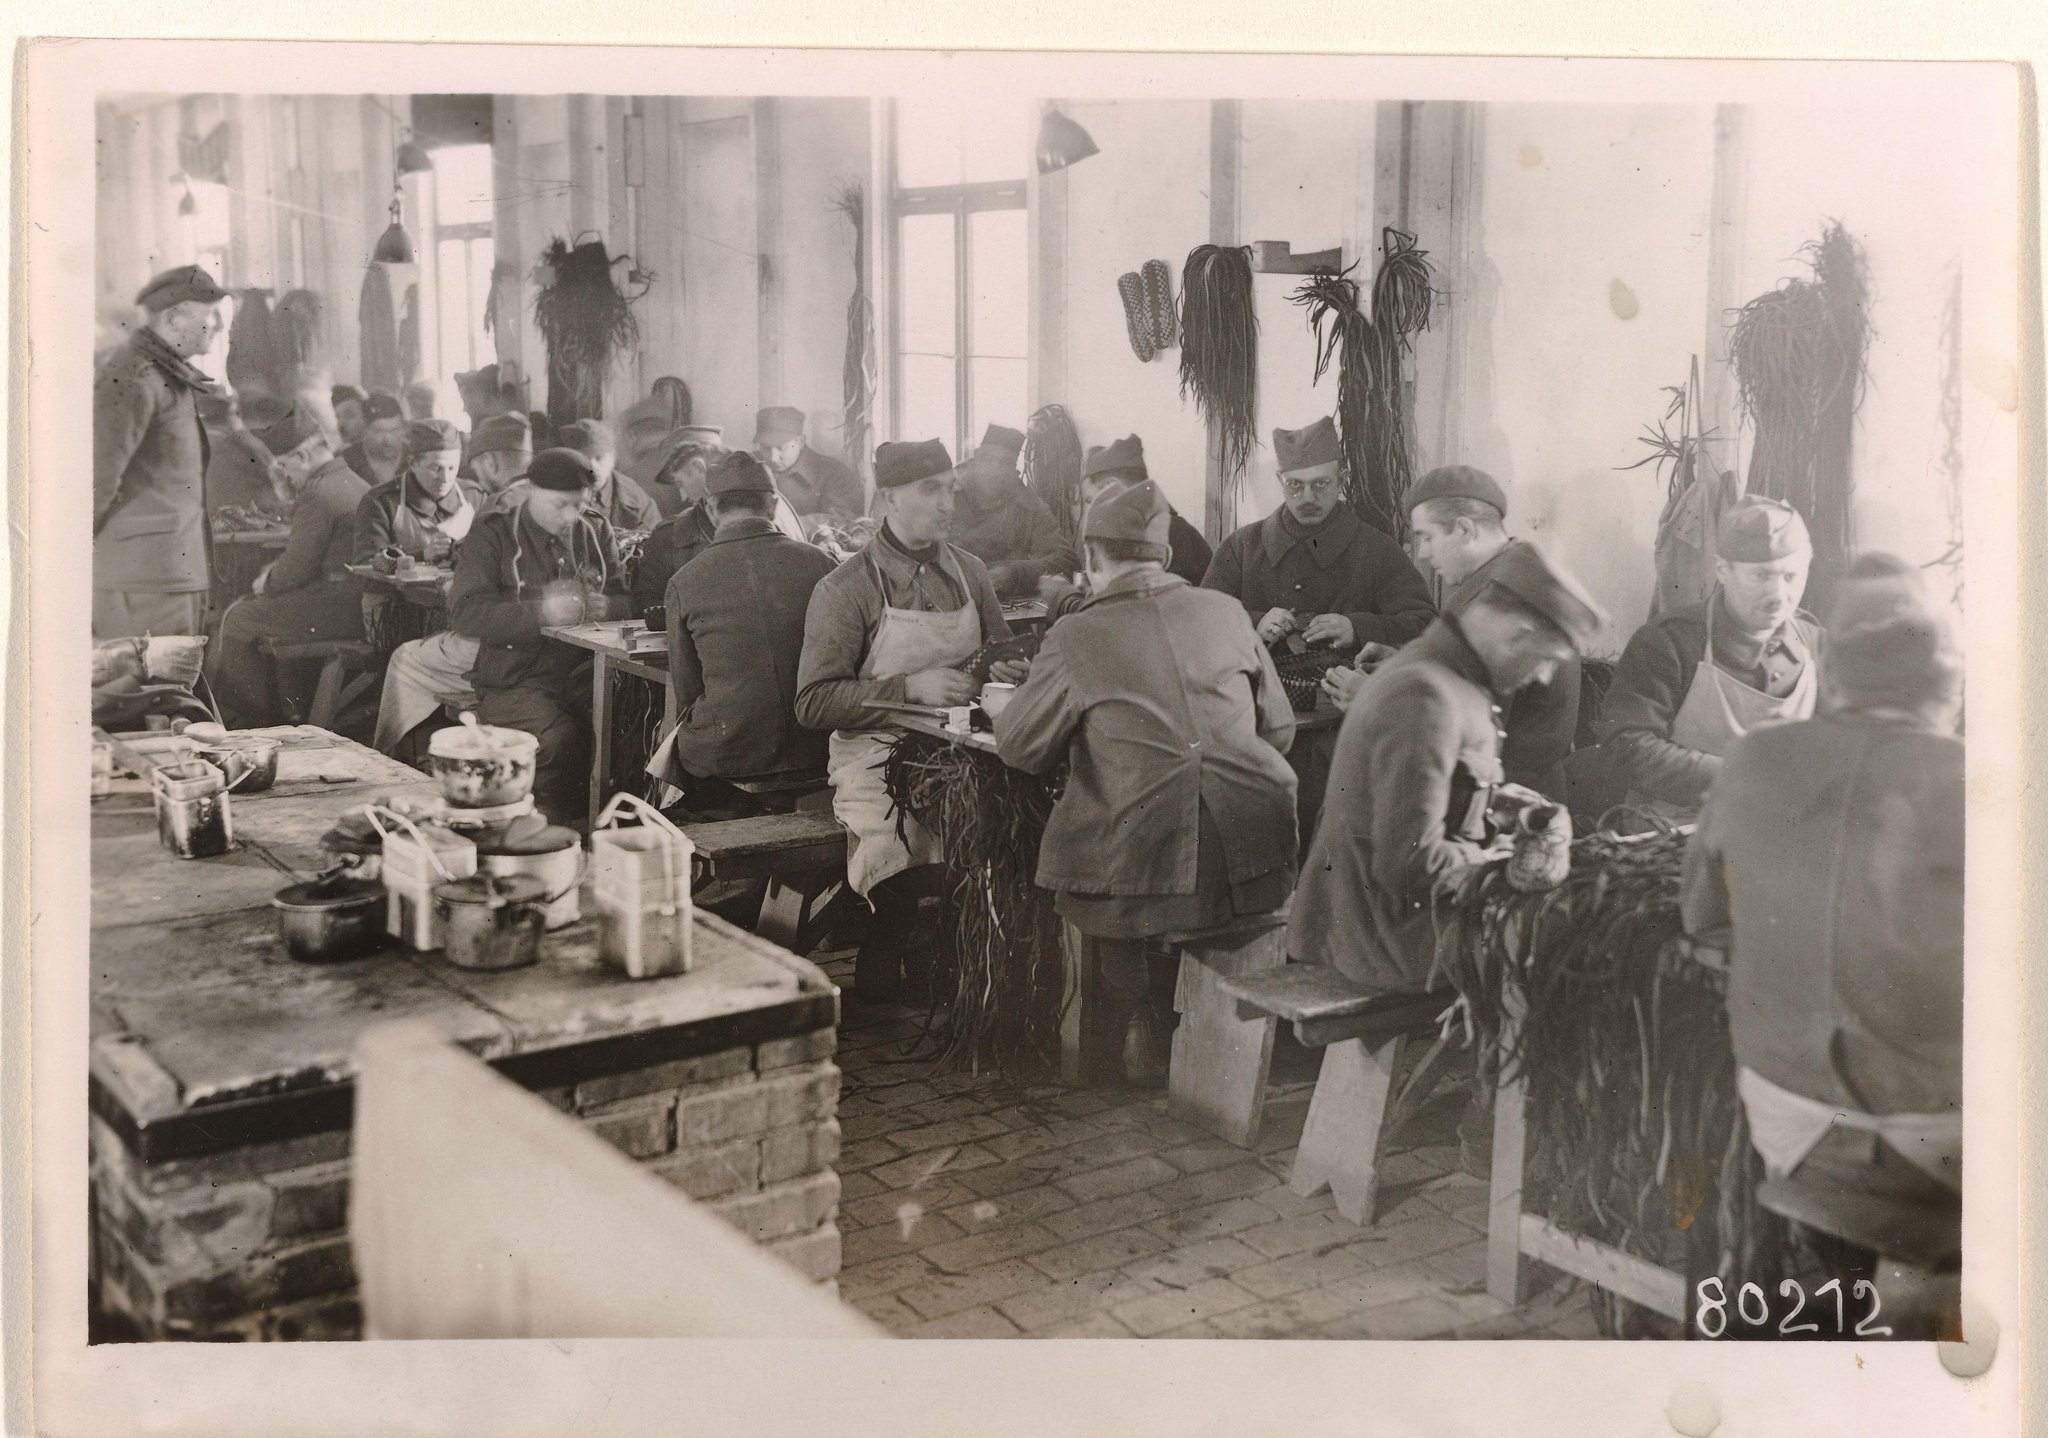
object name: photograph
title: Werkplaats voor schoenen vlechten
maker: dick w.b. van maarseveen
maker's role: fotograaf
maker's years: 1905-1990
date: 1943-1945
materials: photographic support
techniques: gelatin silver print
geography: muhlberg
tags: the hague, dick w.b. van maarseveen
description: Werkplaats waar krijgsgevangenen een soort schoentjes vlechten. Onderdeel van een groep foto's gemaakt door Dick van Maarseveen in het Duitse krijgsgevangenenkamp Stalag IV B in Mühlberg in de periode 1943-1945.